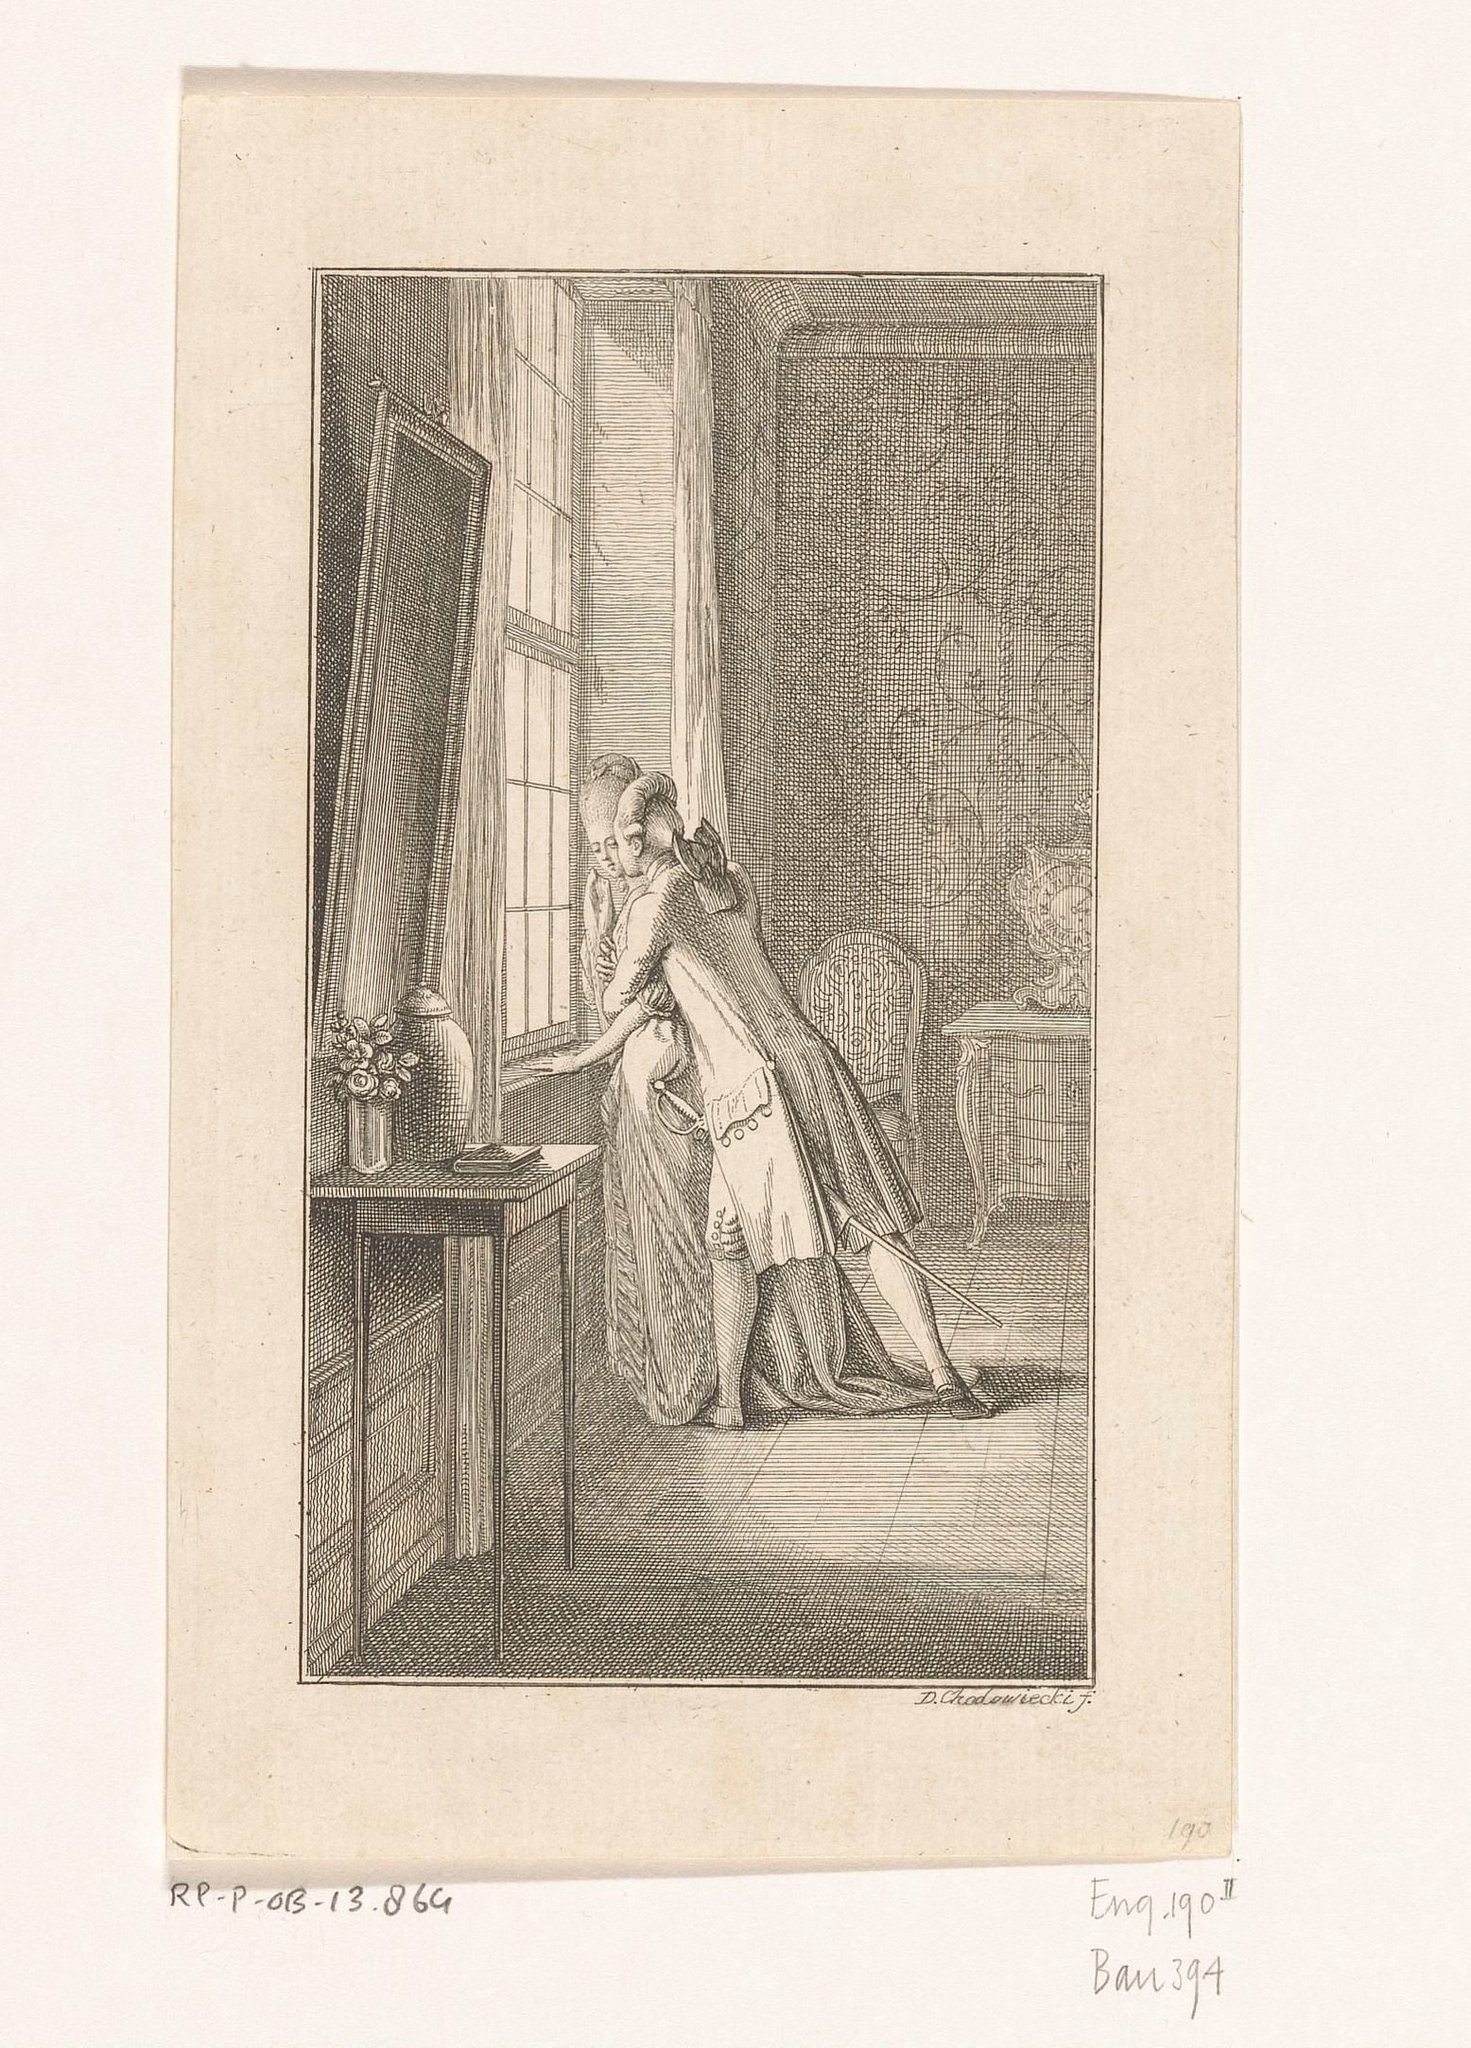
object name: print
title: Carl Ferdiner probeert Elise te omhelzen voor het raam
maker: daniel nikolaus chodowiecki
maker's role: draughtsman, print maker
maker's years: 1726-1801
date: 1777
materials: paper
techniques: etching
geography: berlin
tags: literature, (lovers) kissing each other, human figure at (open) window, seen from inside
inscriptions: collector's mark: Lugt 2228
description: De derde staat van deze prent is ook gebruikt in: Dusch, Johann Jakob. Geschichte Carl Ferdiners. 3 dln. Breslau en Leipzig: Johann Ernst Meyer, 1777-1780.